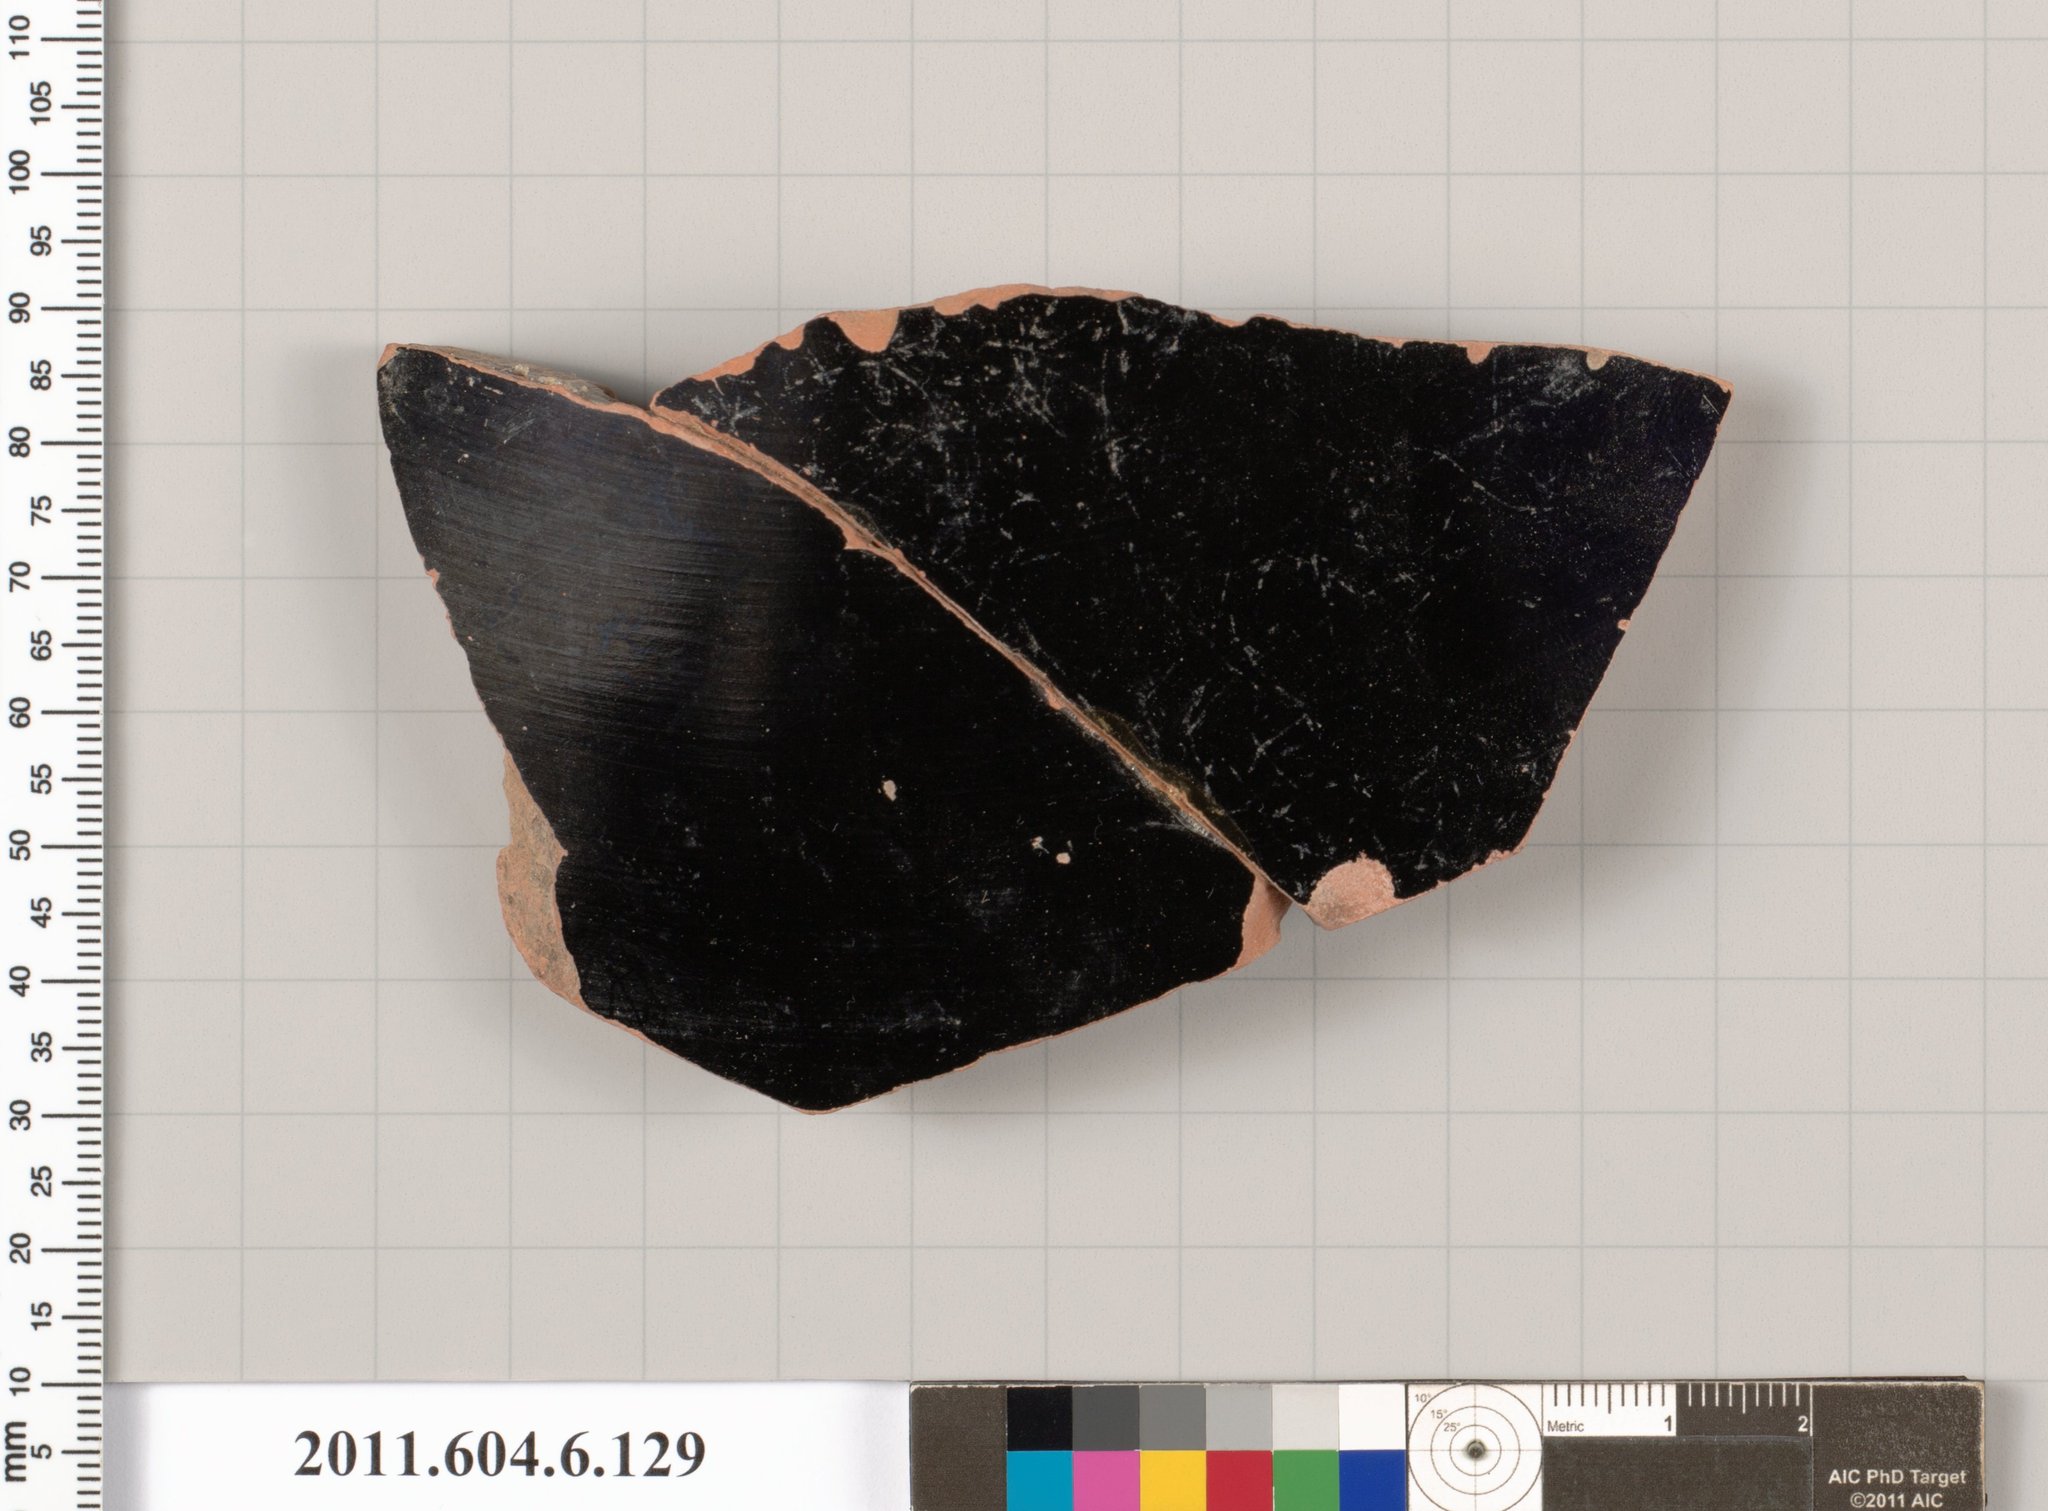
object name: undetermined open shape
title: Terracotta fragment of an open shape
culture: greek, attic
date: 600-401 BCE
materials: terracotta